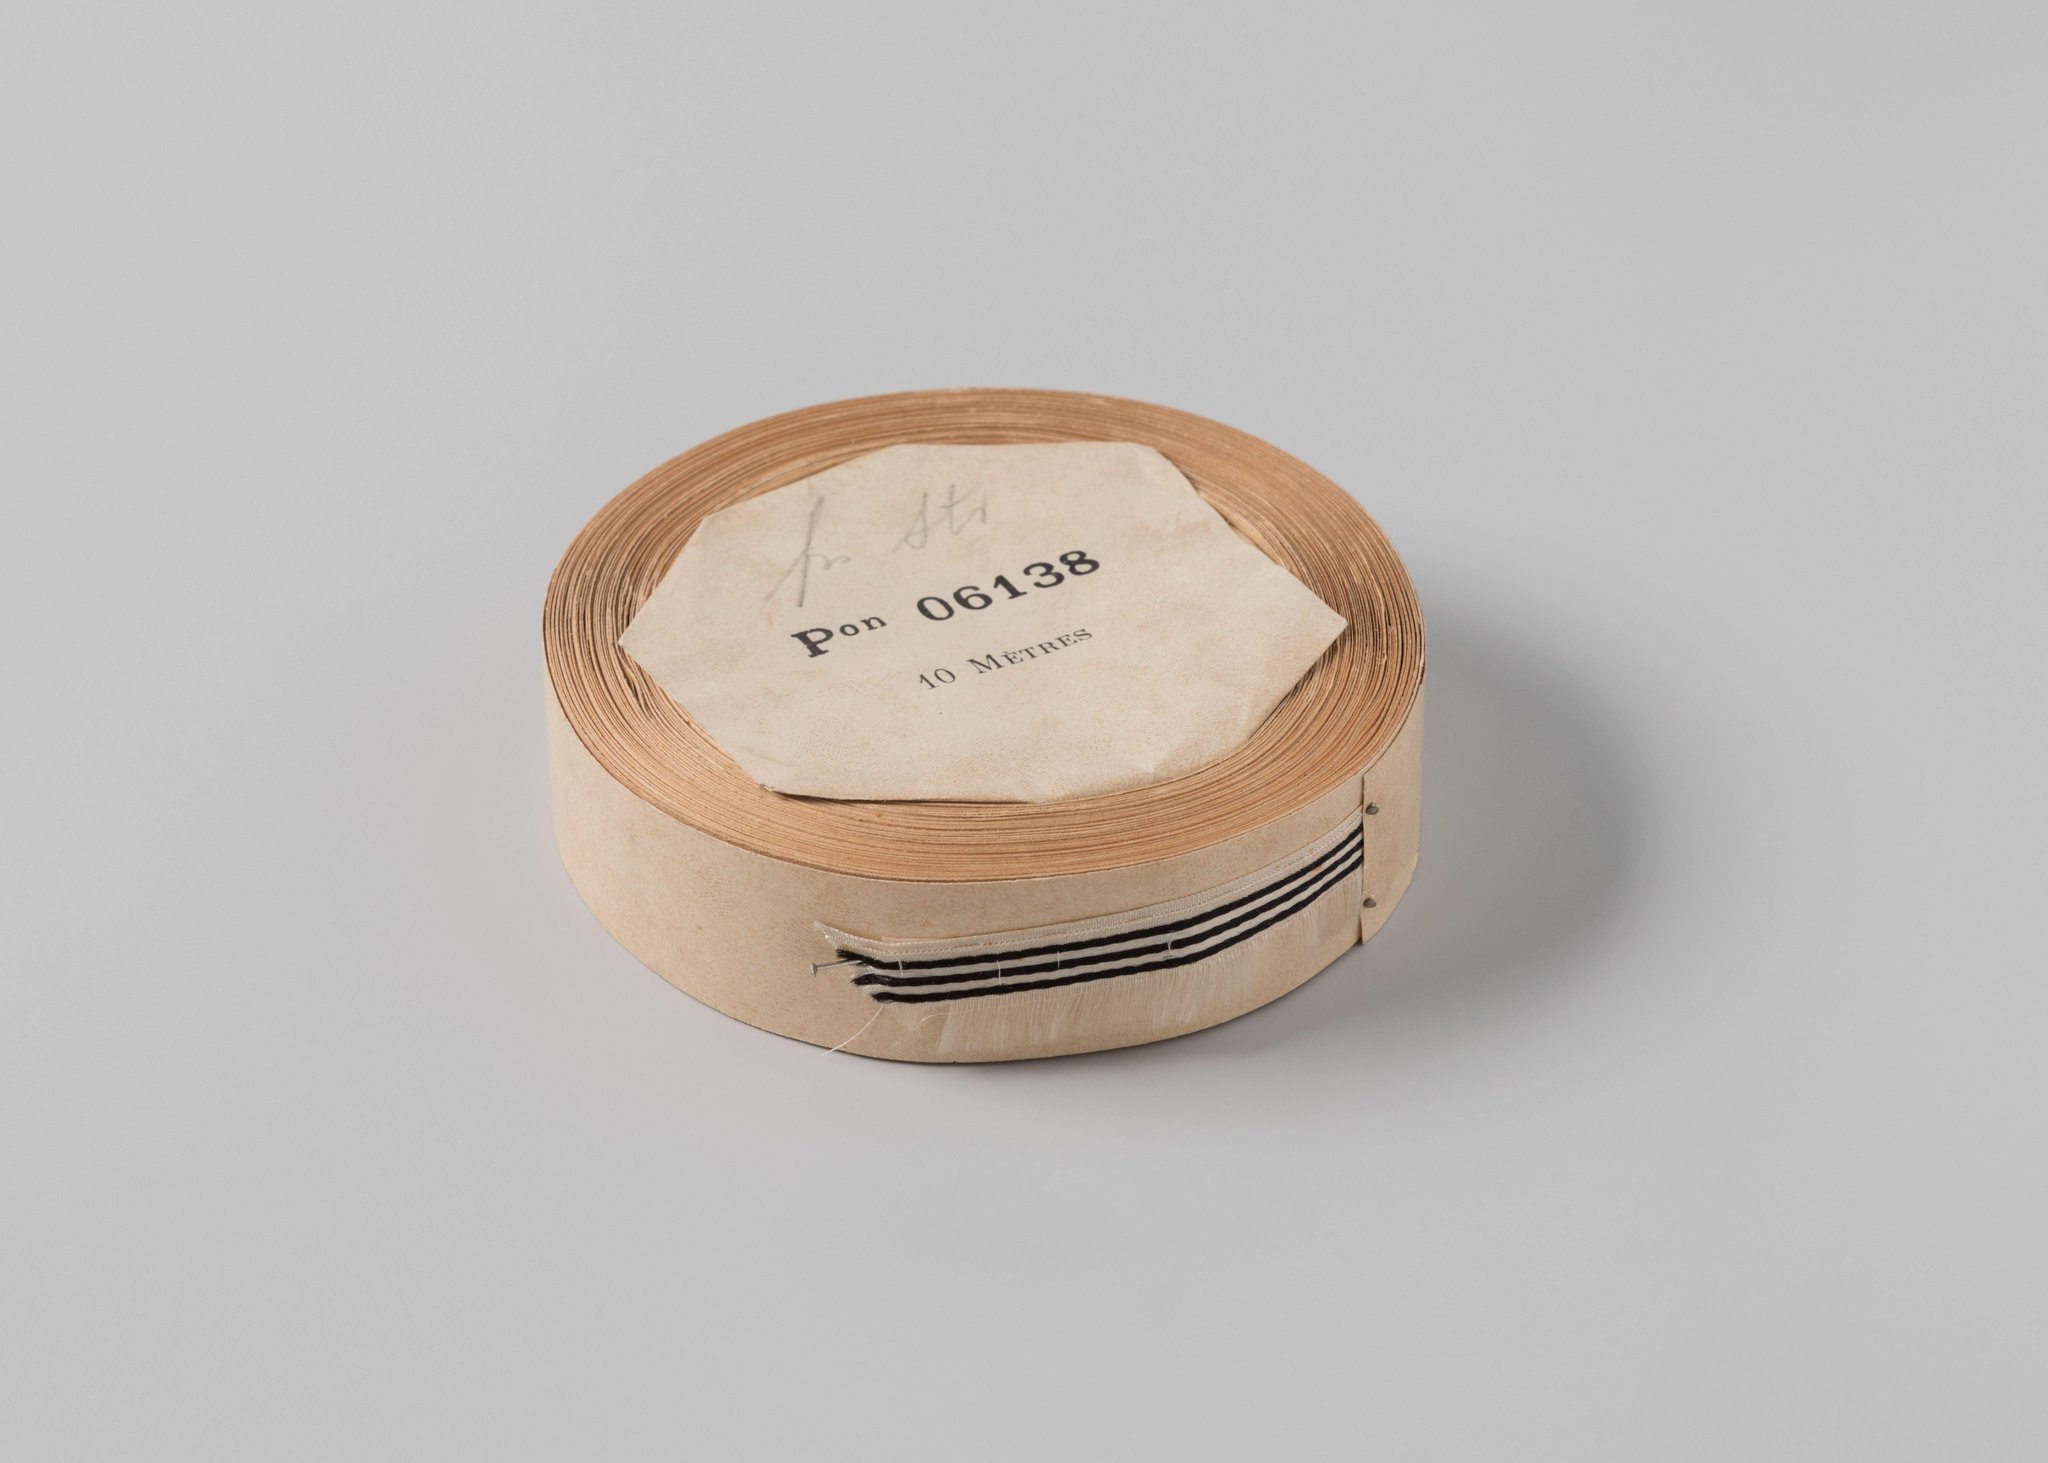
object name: braid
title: Rol met wit lint met één gerafelde zijde en drie zwarte horizontale strepen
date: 1930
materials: cardboard, paper, textile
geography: nijmegen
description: Rol met wit lint met één gerafelde zijde en drie zwarte horizontale strepen.